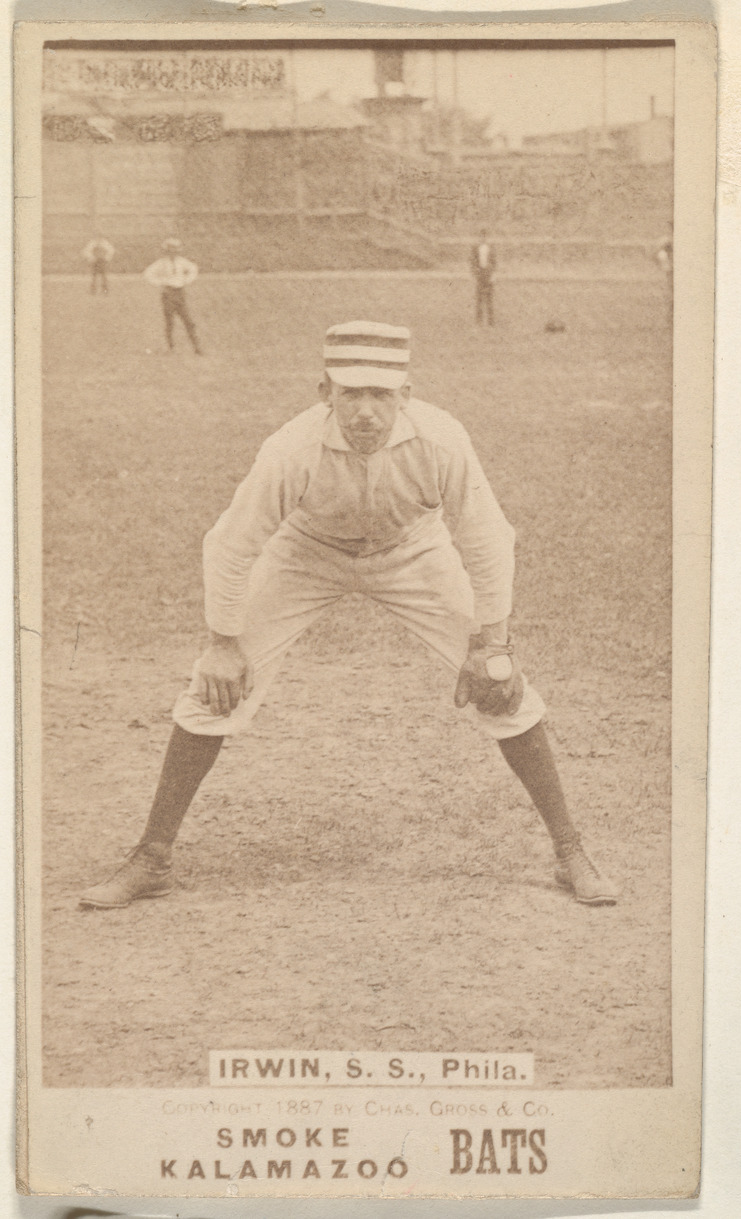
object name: baseball card, photograph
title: Irwin, Shortstop, Philadelphia, from the Kalamazoo Bats series (N690) issued by Chas. Gross & Co. to promote Kalamazoo Bats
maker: chas. gross & co.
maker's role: publisher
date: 1887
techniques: albumen silver print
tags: men,portraits,baseball,athletes